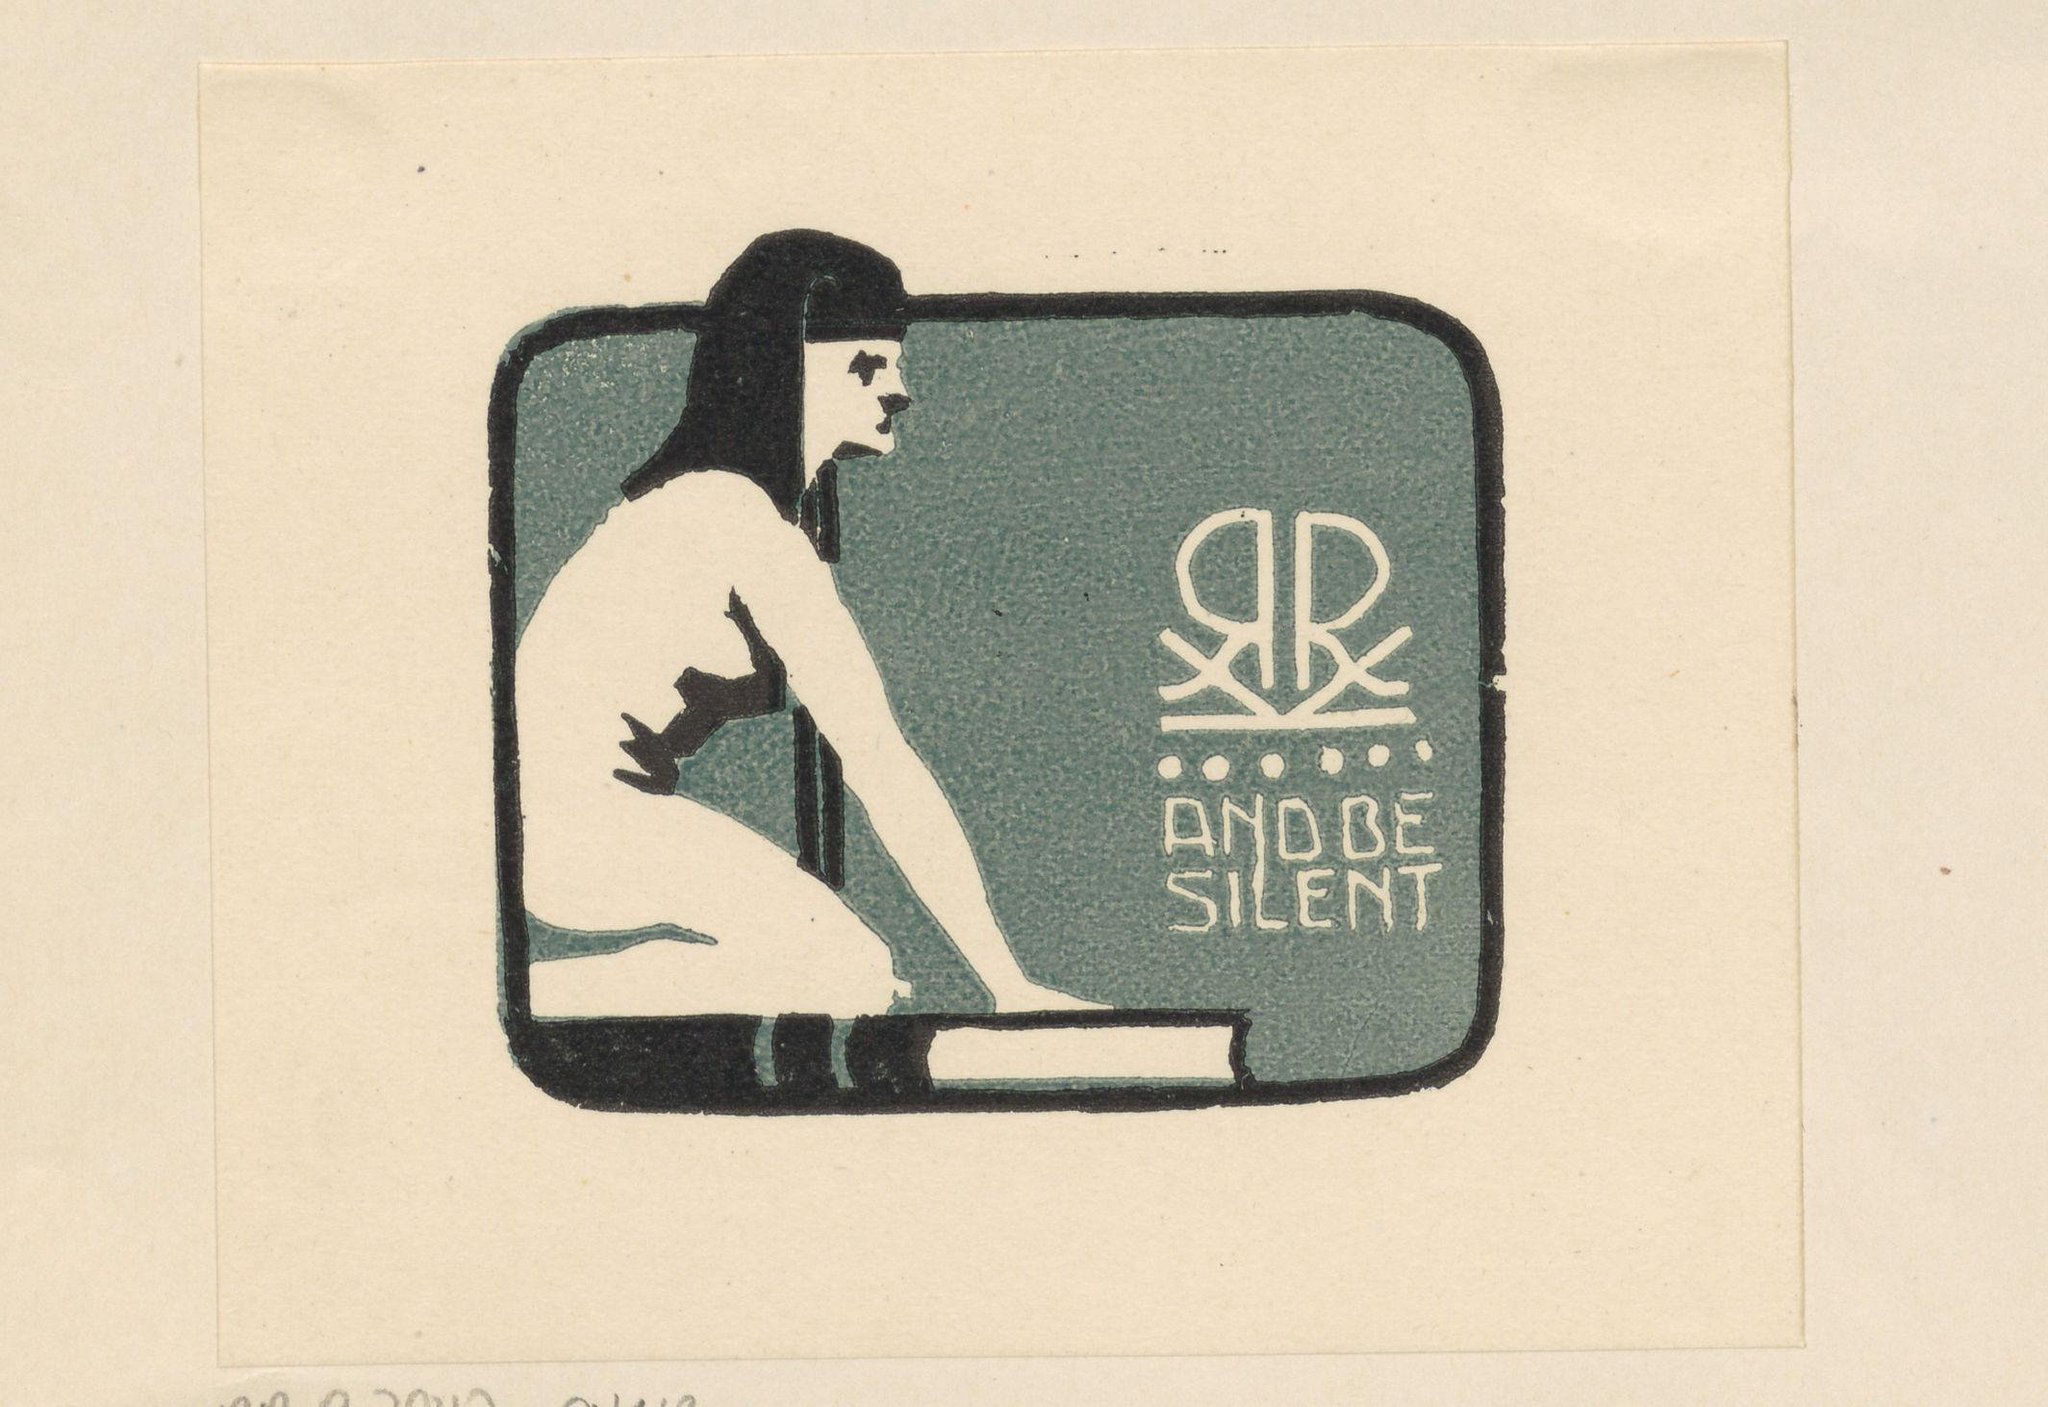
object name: bookplate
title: Ex libris, mogelijk van R.K.R.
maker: Anonymous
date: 1900-1999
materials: paper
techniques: linocut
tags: sitting figure - aa - female human figure, woman (showing herself) undressed, quasi-nude, book